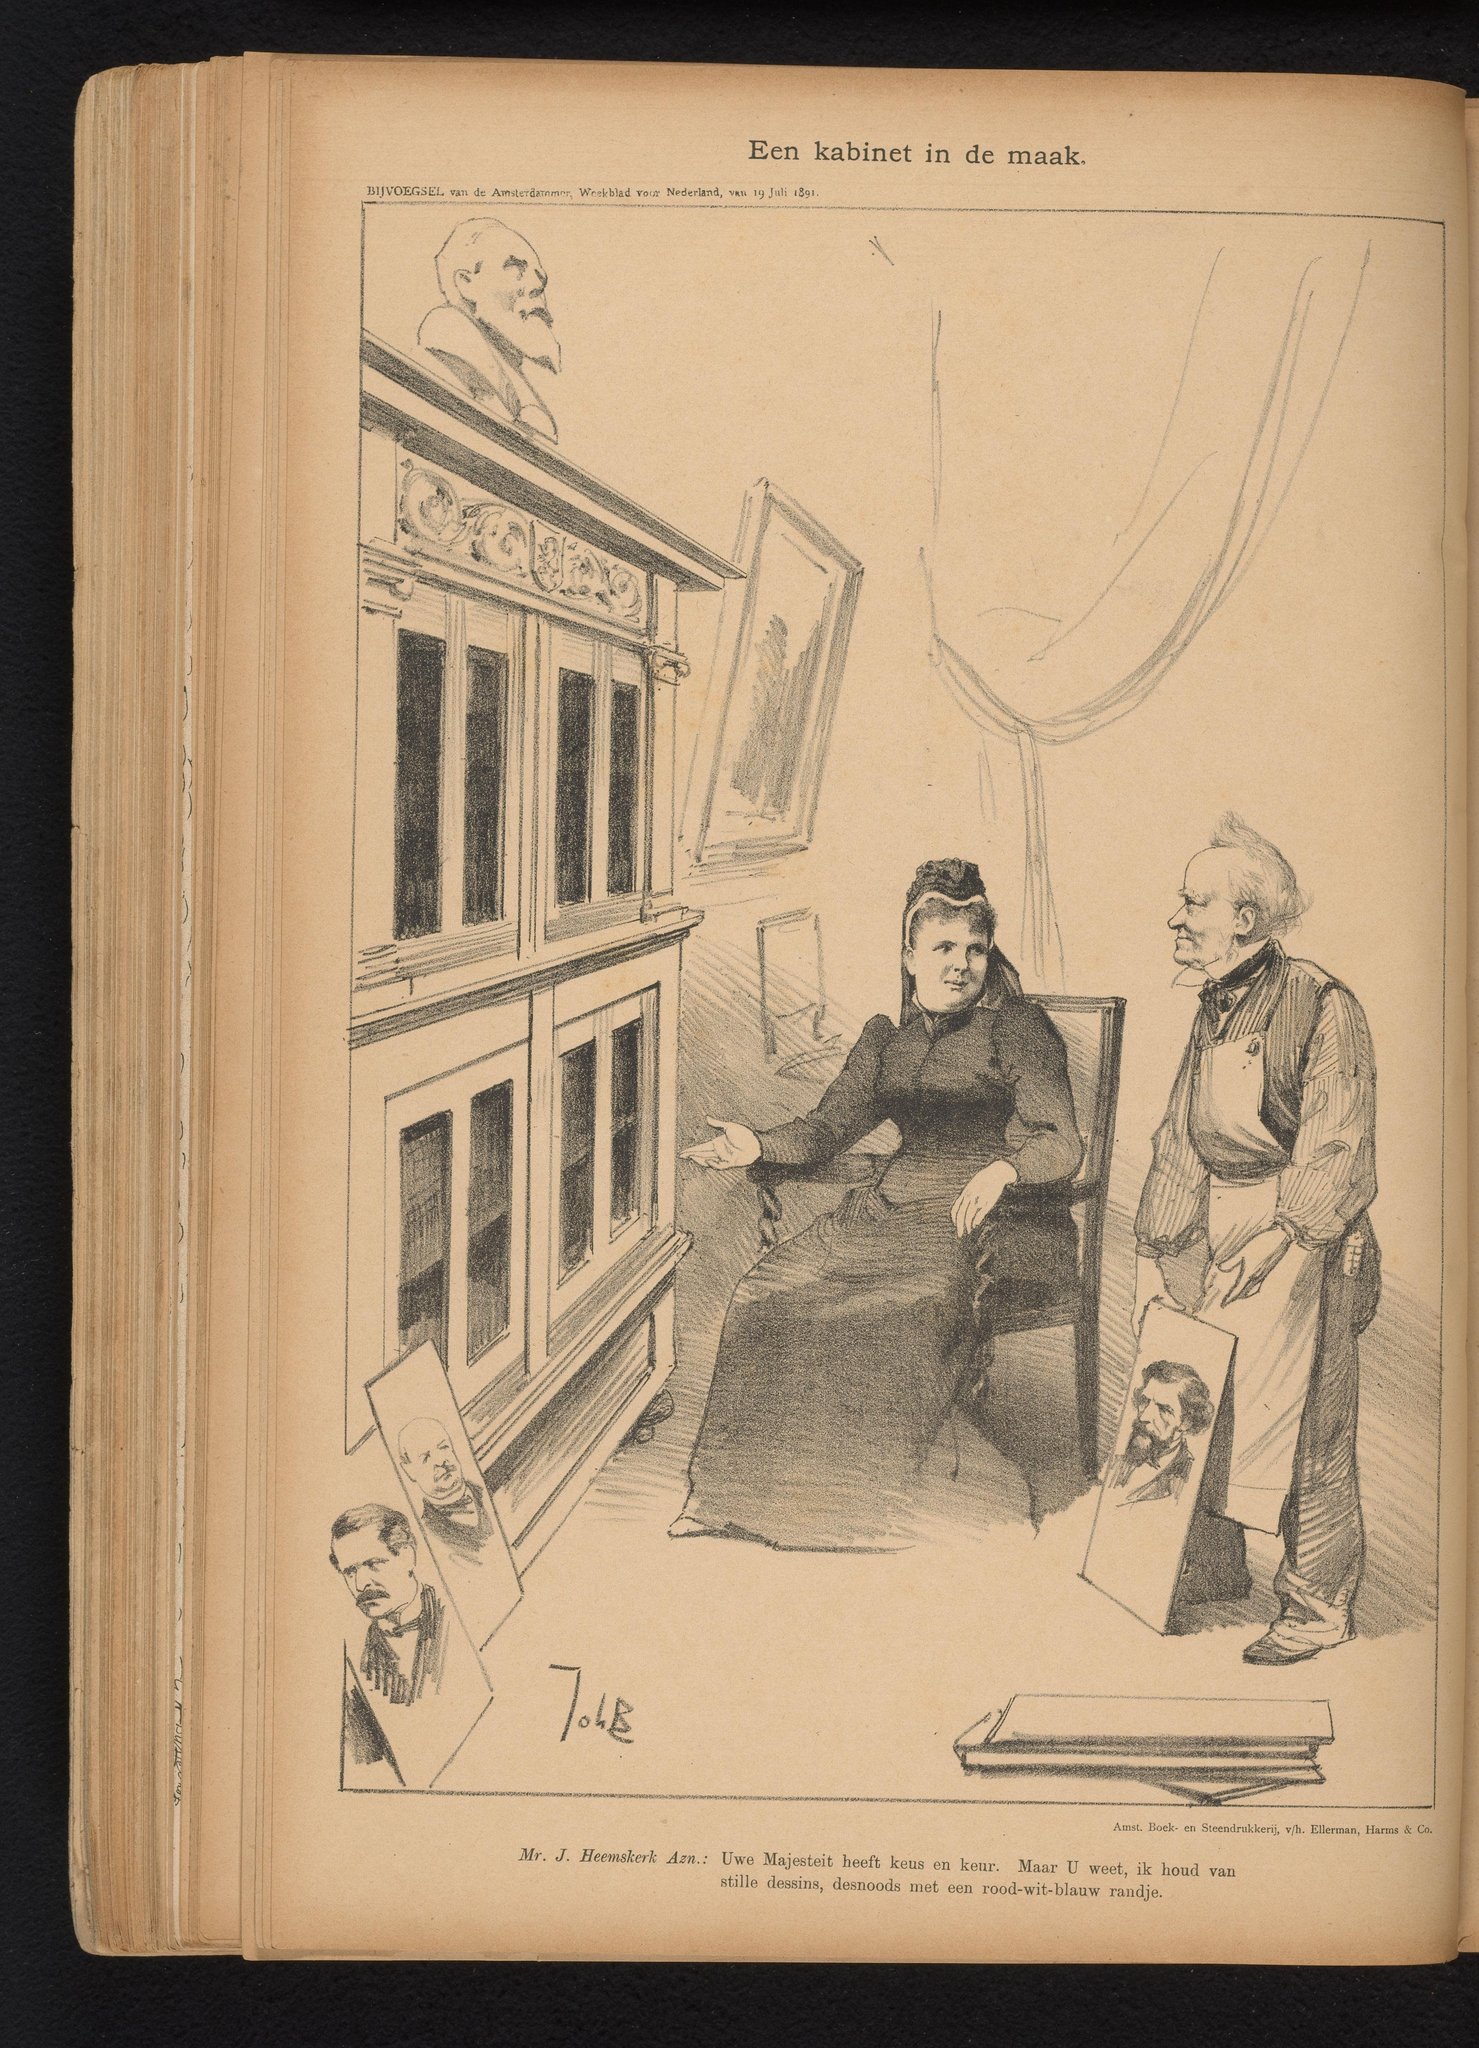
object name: cartoon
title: Een kabinet in de maak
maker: johan braakensiek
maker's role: draughtsman, print maker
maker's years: 1858-1940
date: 1891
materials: paper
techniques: lithograph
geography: netherlands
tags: emma (queen consort of the netherlands), mayor, gijsbert van tienhoven, amsterdam, the hague, joiner, cabinet maker, 'ébéniste', minister ~ government, political caricatures and satires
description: Voormalig premier Heemskerk als meubelmaker die het kabinet Van Tienhoven aan het opbouwen is. Hij overlegt met koningin-regentes Emma. Op de vloer wacht het portret van Tak van Poortvliet en een andere kandidaat minister.